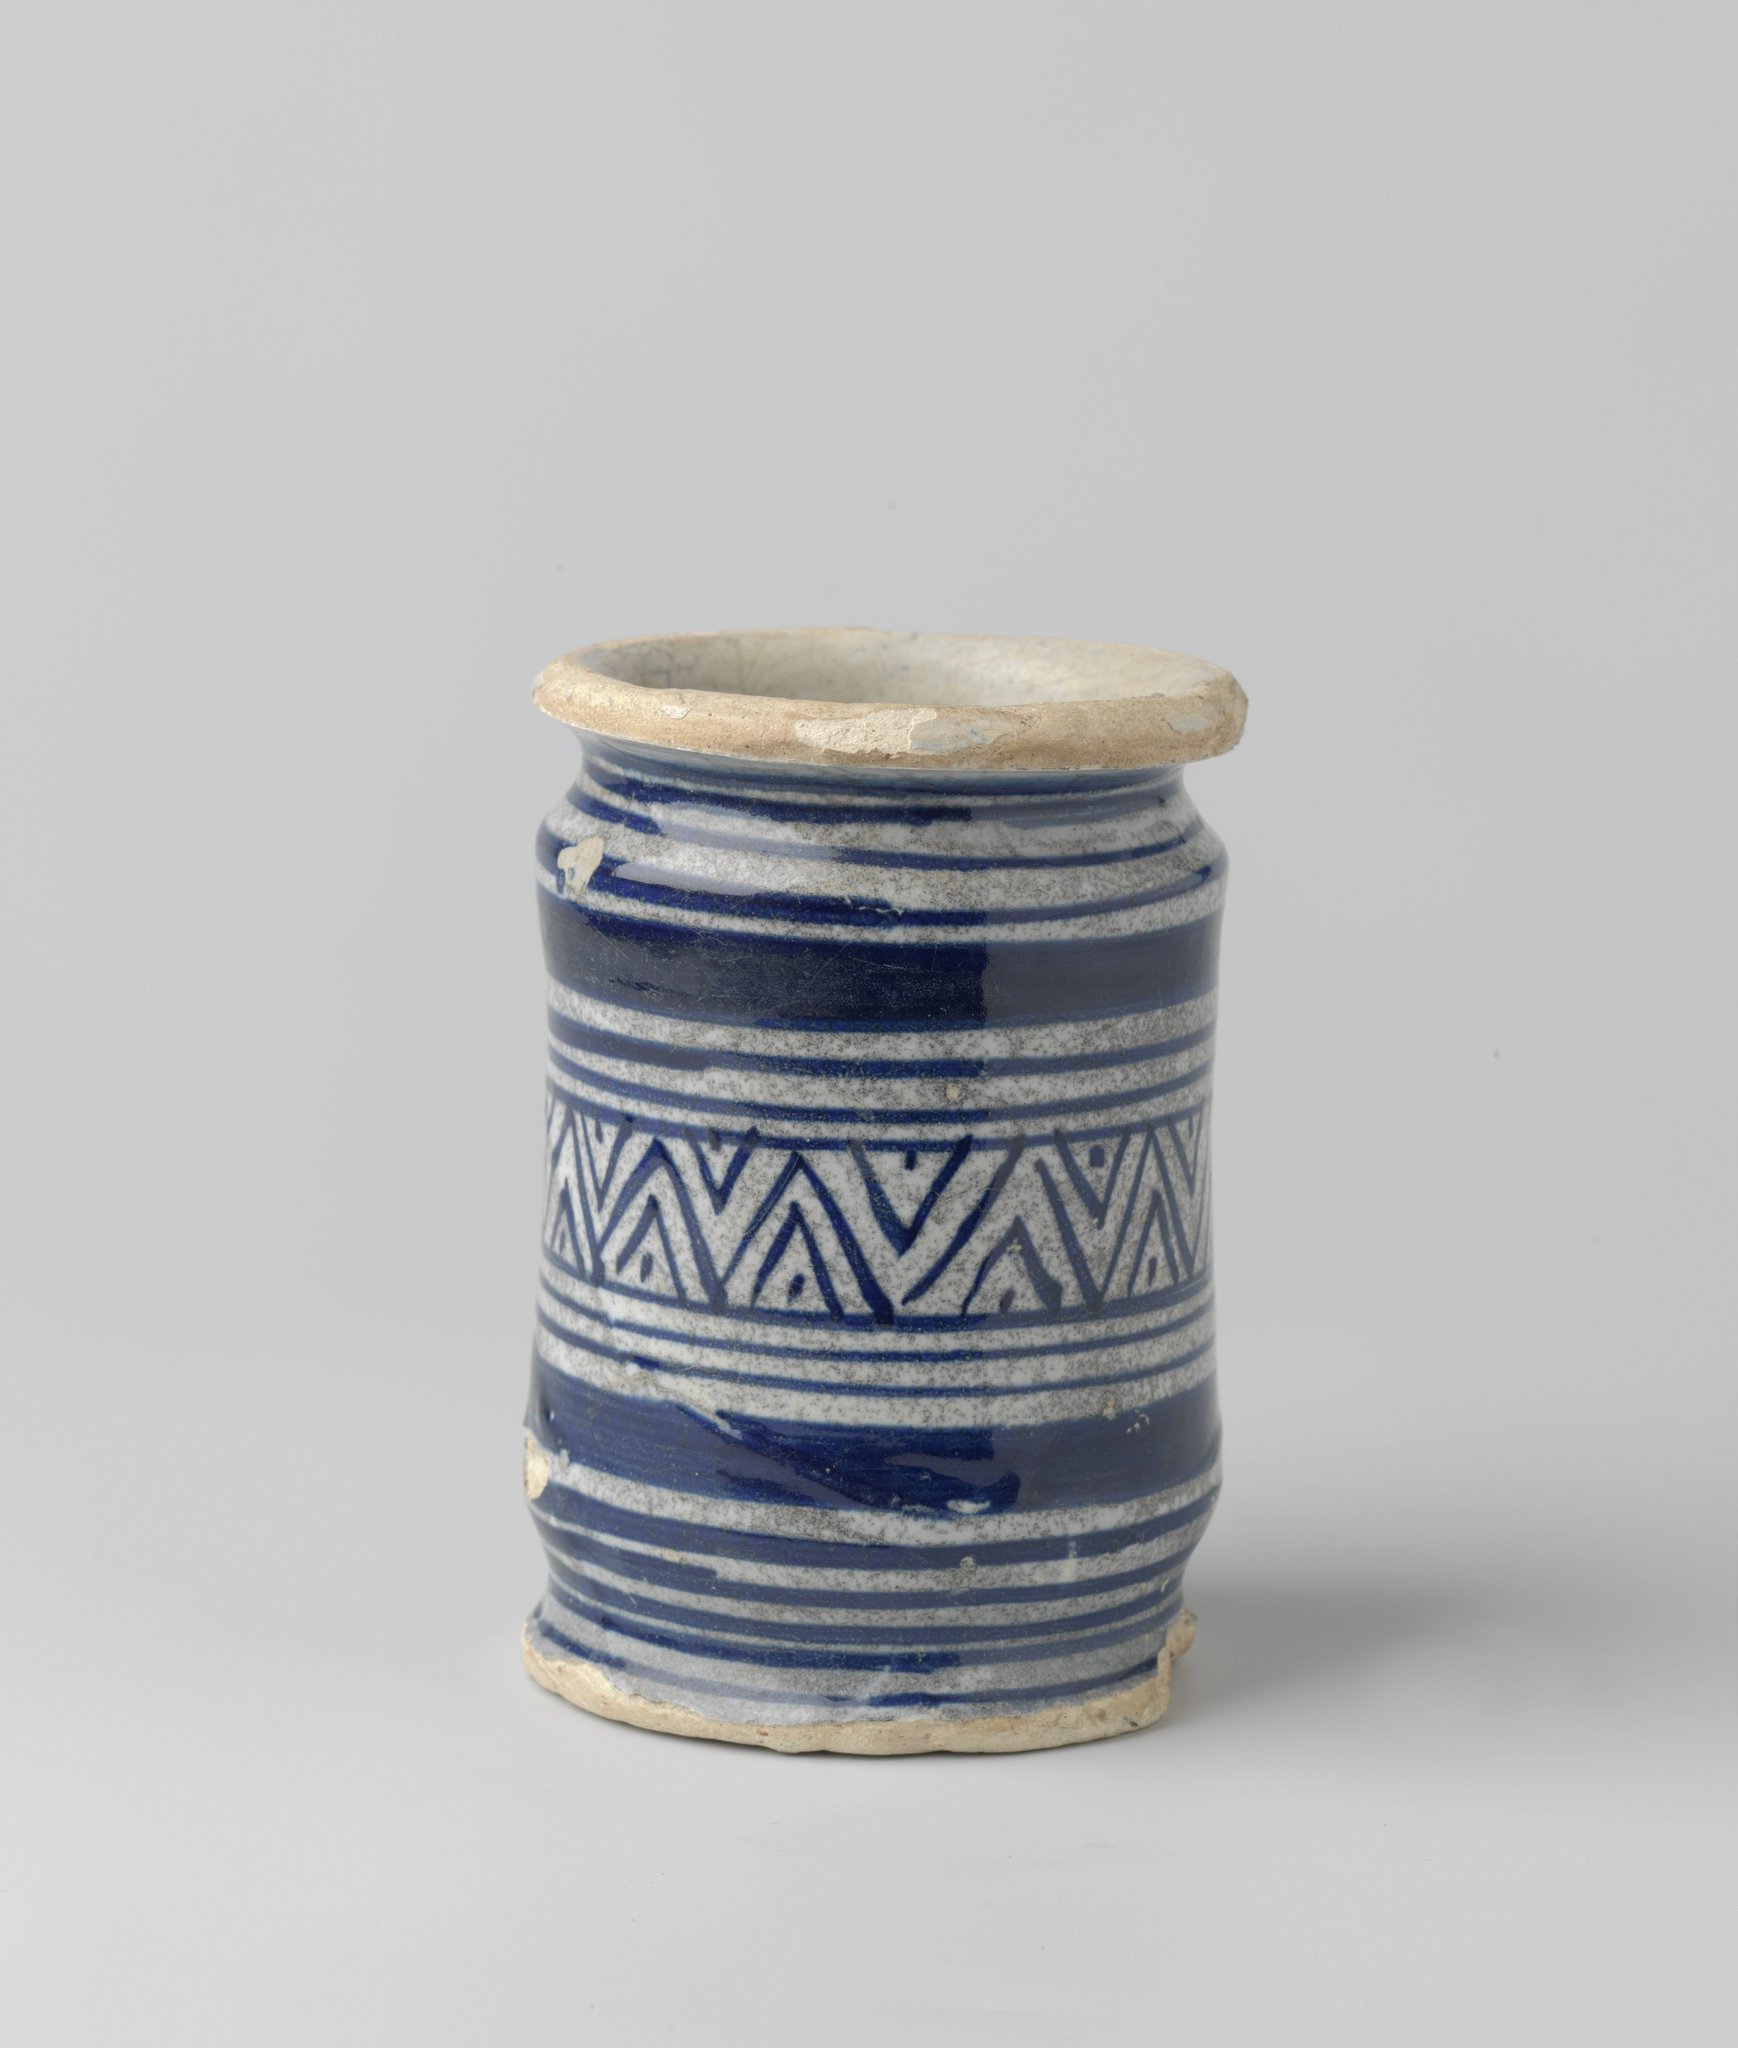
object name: pot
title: Pot, blauw-wit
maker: Anonymous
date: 1600-1650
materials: earthenware, glaze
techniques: maiolica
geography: northern netherlands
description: Pot, blauw-wit, deel van een partij Noord-Nederlandsche majolica en ander aardewerk, gevonden bij het graafwerk voor de uitbreiding van het Scheepvaarthuis op het Waelseiland.